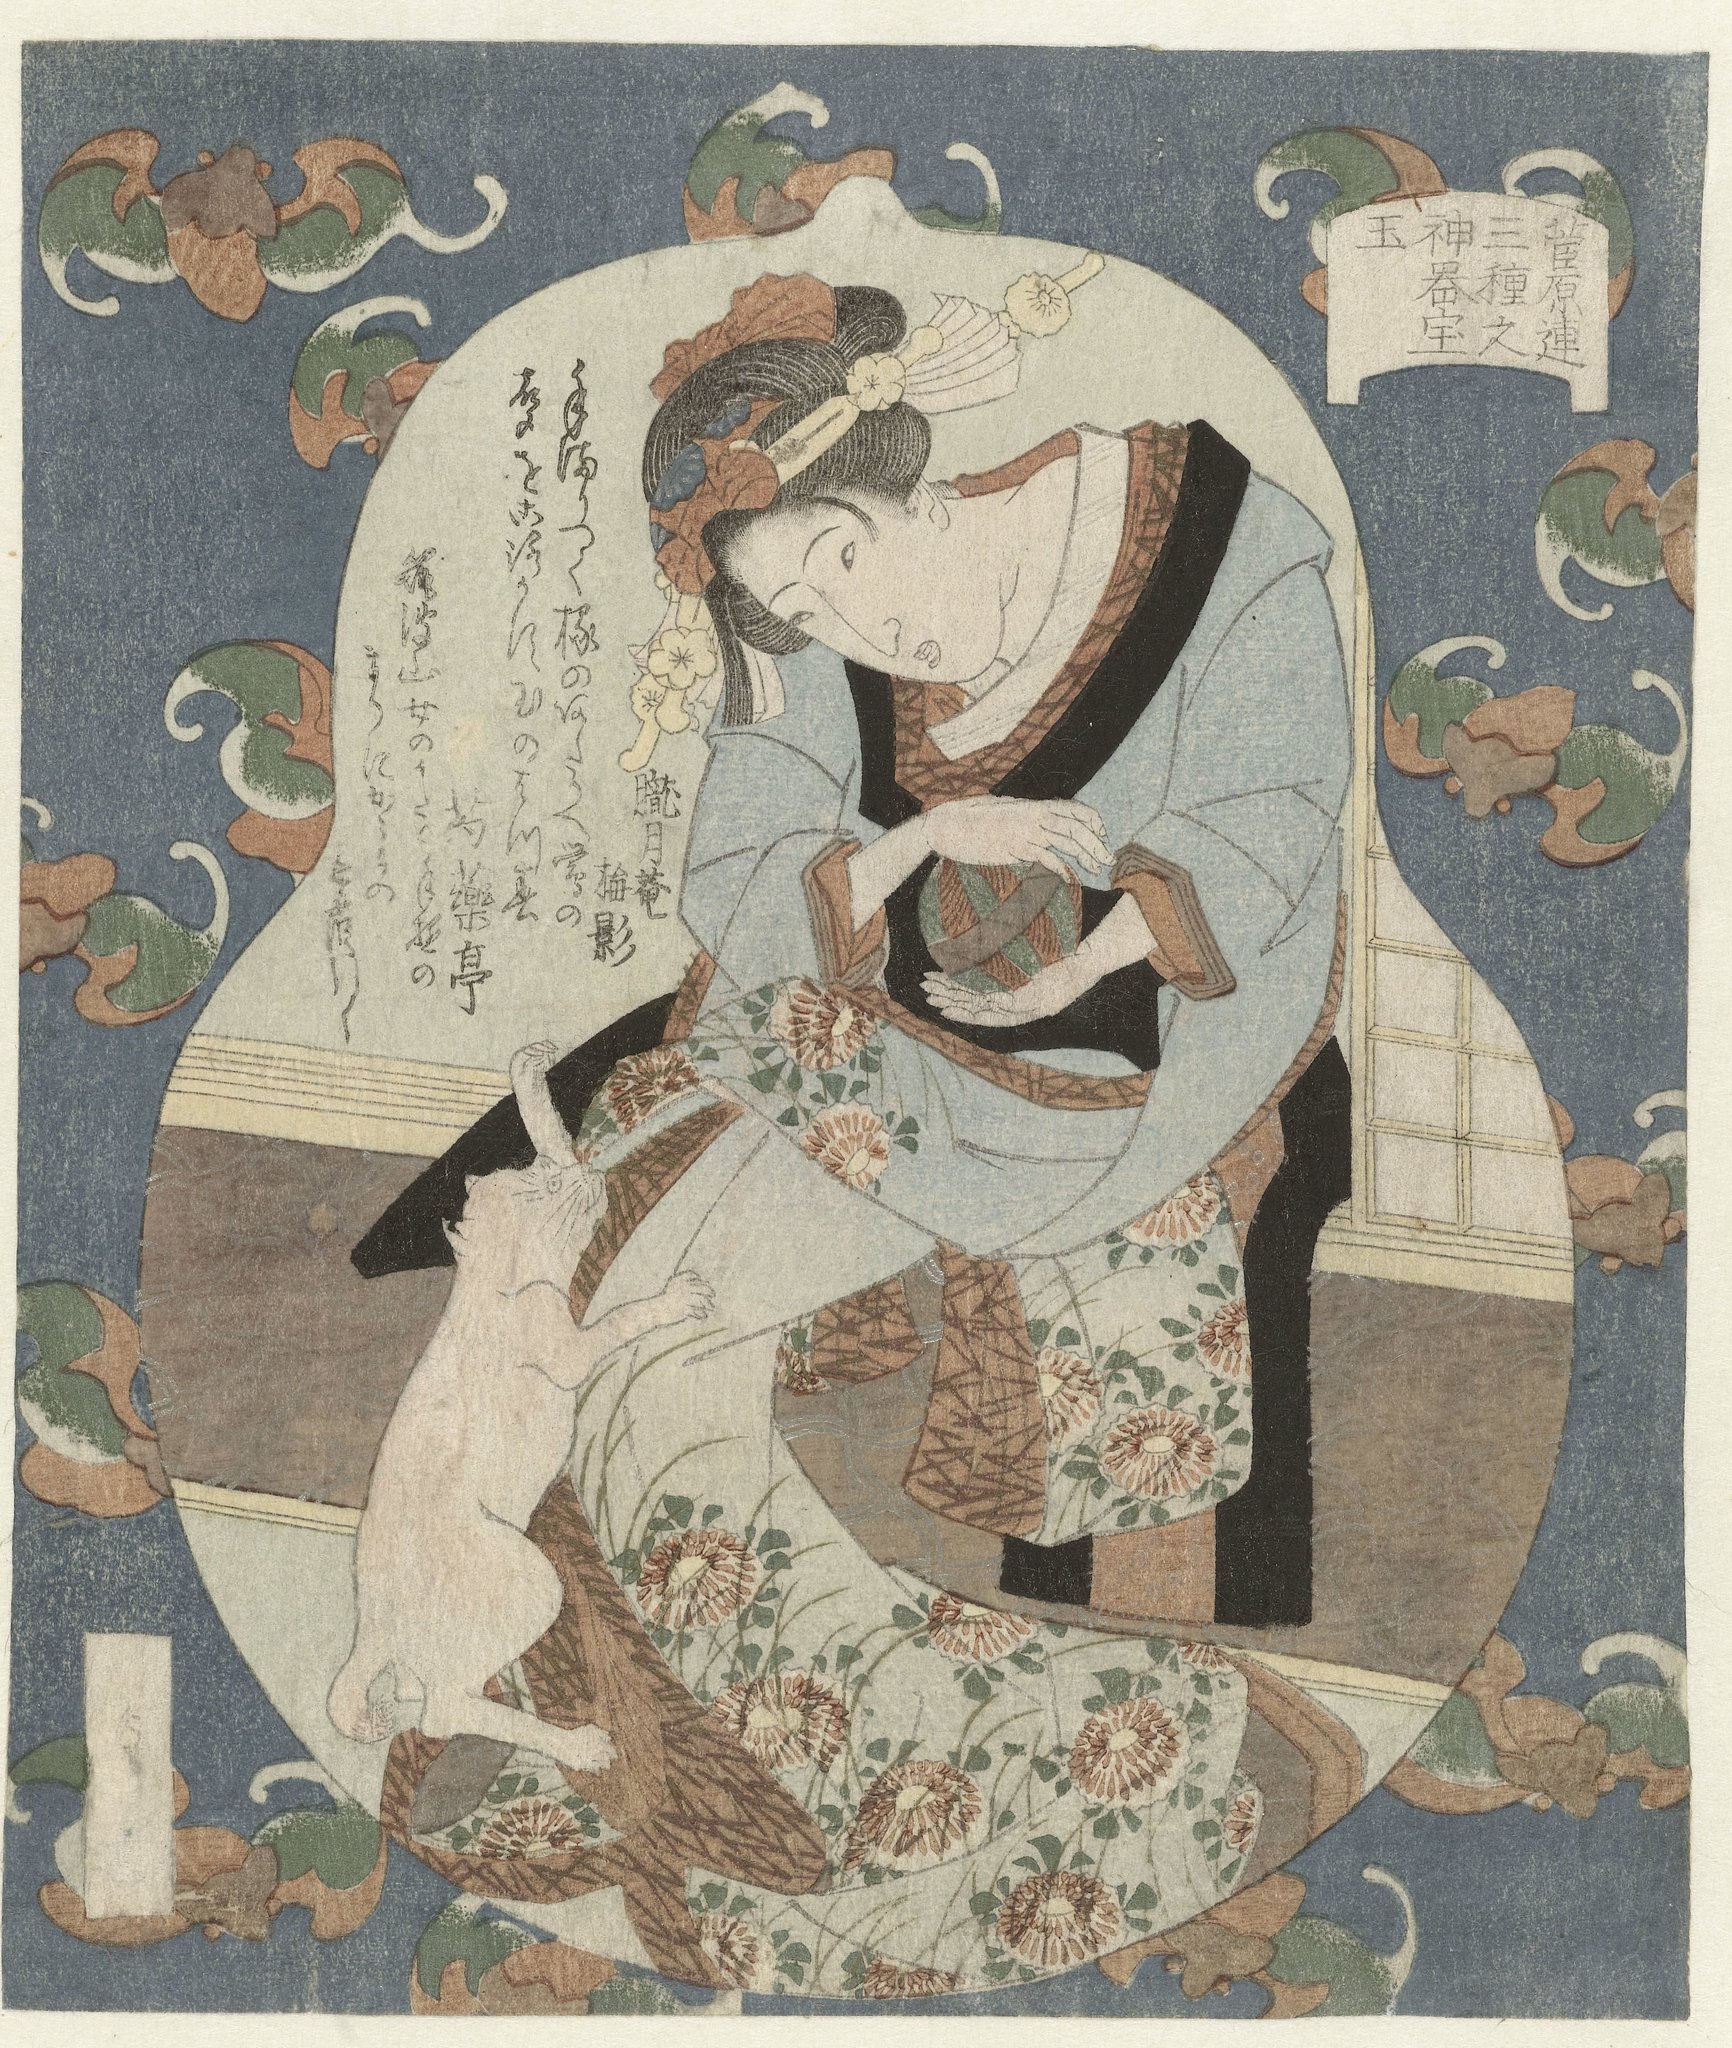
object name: surimono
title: Bal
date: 1830-1835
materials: paper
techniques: blind stamped, woodcut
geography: japan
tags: cat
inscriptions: collector's mark, passe-partout, bottom left, printed: JABdH with a rooster., collector's mark, verso, stamped: Lugt 2228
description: Een surimono is een luxe uitgevoerde prent waarop beeld met één of meerdere gedichten gecombineerd is. Bij het drukken van een surimono werd vaak gebruik gemaakt van dikker papier, blinddruk en metaal pigmenten, zoals koper- en zilverpoeder. De prenten werden vaak in opdracht van dichters gemaakt en als exclusief geschenk aan vrienden en relaties gegeven.